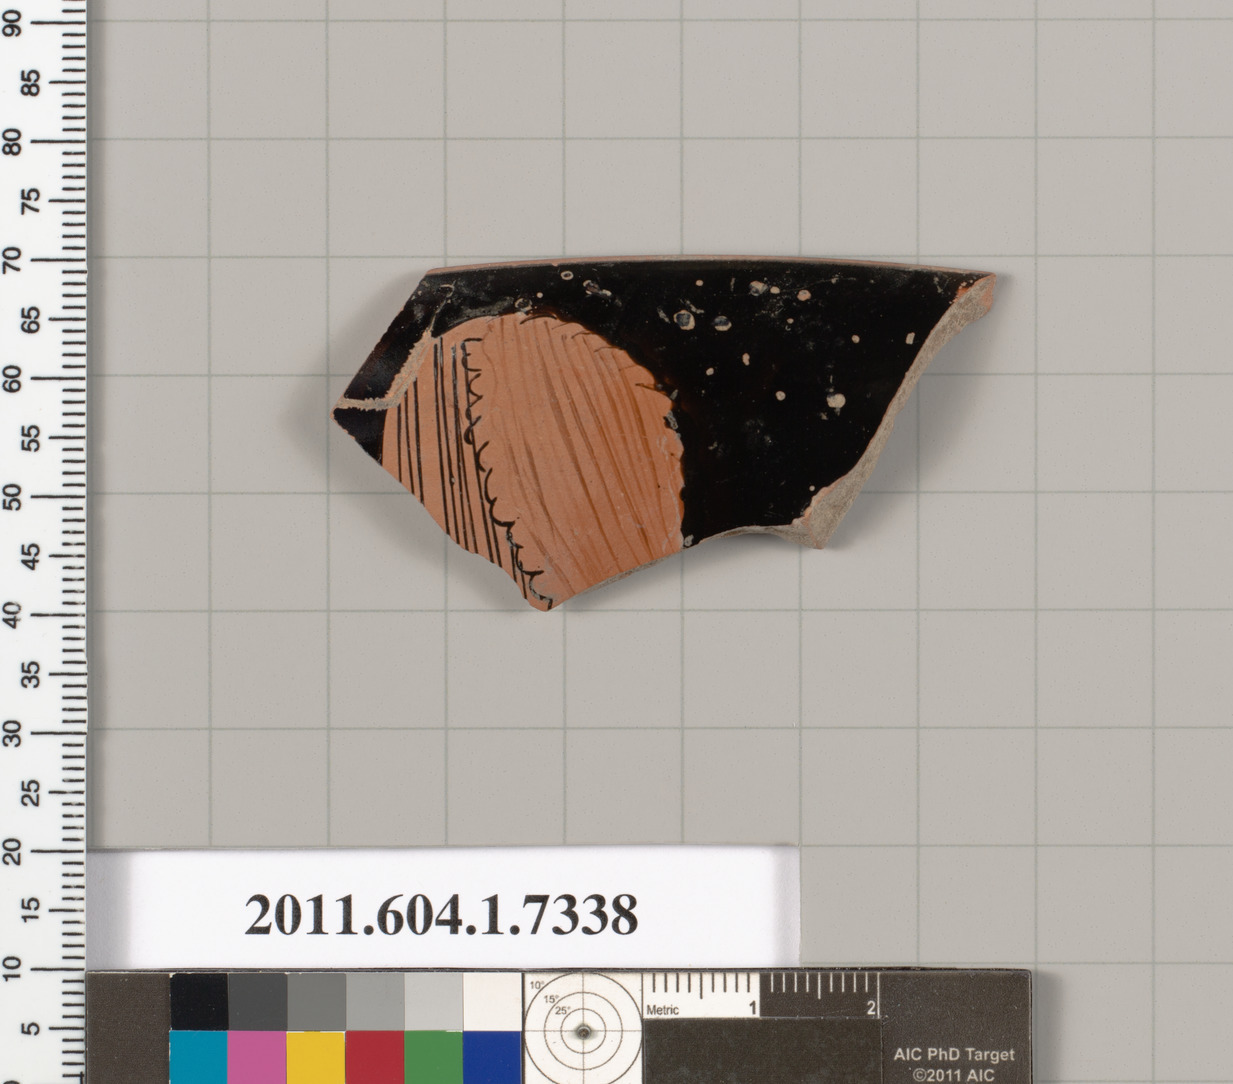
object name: kylix fragment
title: Terracotta rim fragment of a kylix (drinking cup)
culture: greek, attic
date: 500-480 BCE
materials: terracotta